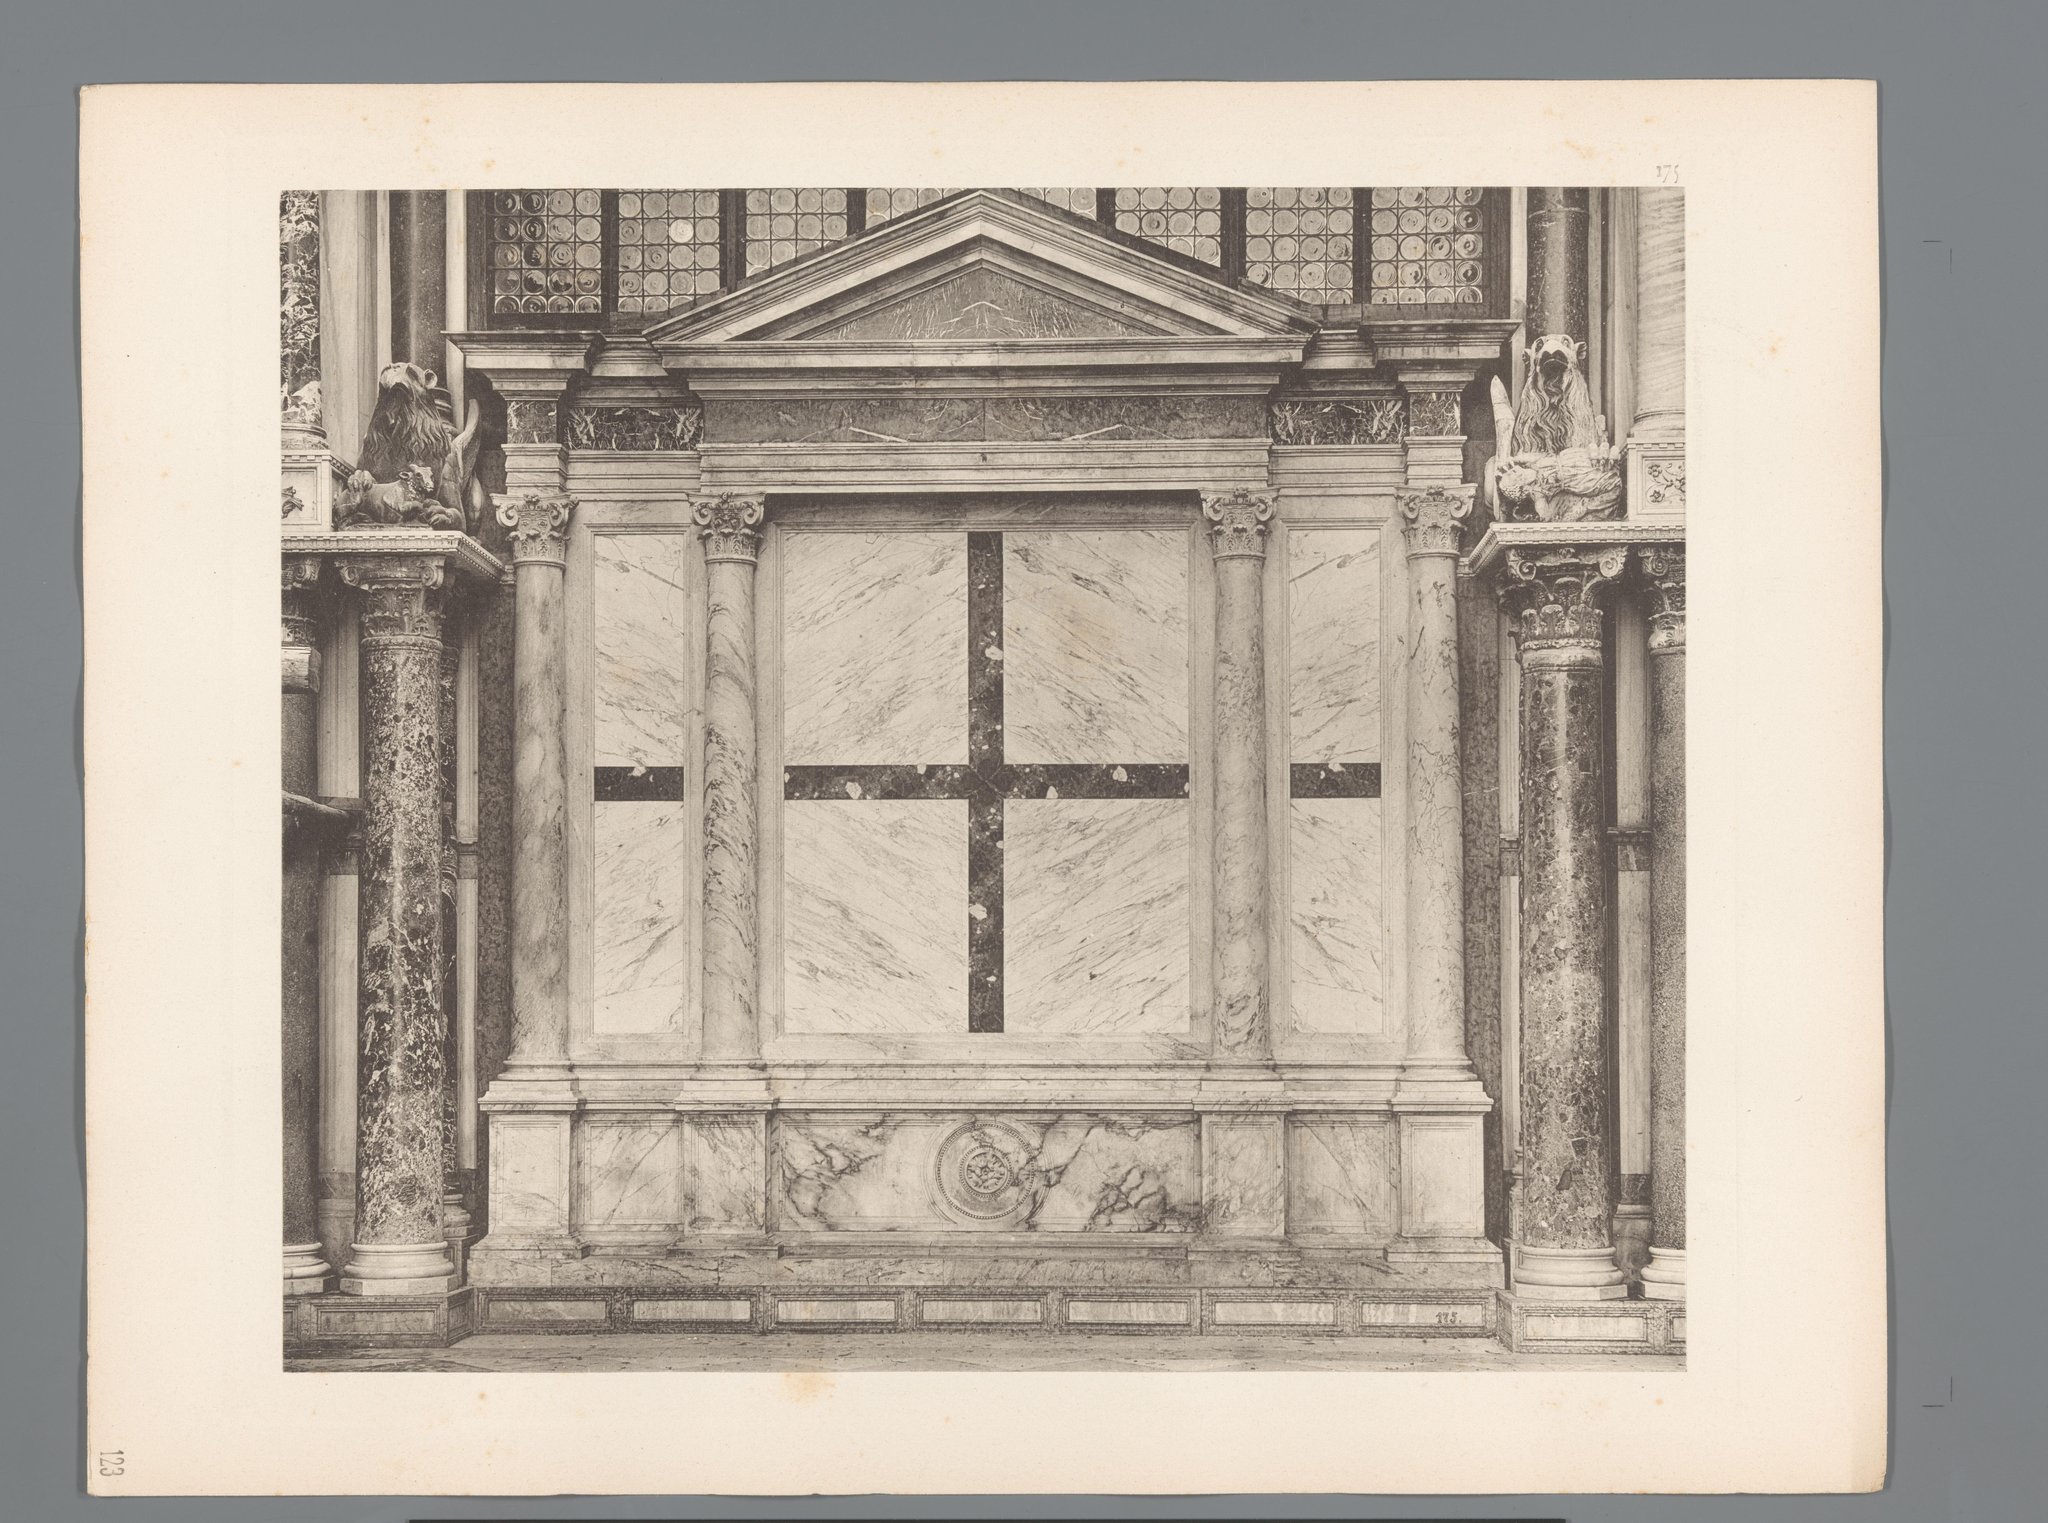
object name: photomechanical print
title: Gezicht op zuilen, een architraaf en timpaan aan de buitenzijde van de San Marco in Venetië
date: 1879-1884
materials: paper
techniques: photograph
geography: venice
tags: column, pillar ~ architecture, church (exterior)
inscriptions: number: ‘175.’, number: ‘123’, number: ‘175’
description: Deze prent maakt deel uit van een omslag met 51 prenten op 29 bladen en 1 tekstblad.